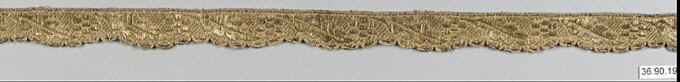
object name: galloon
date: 1767-1833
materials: metal thread, silk